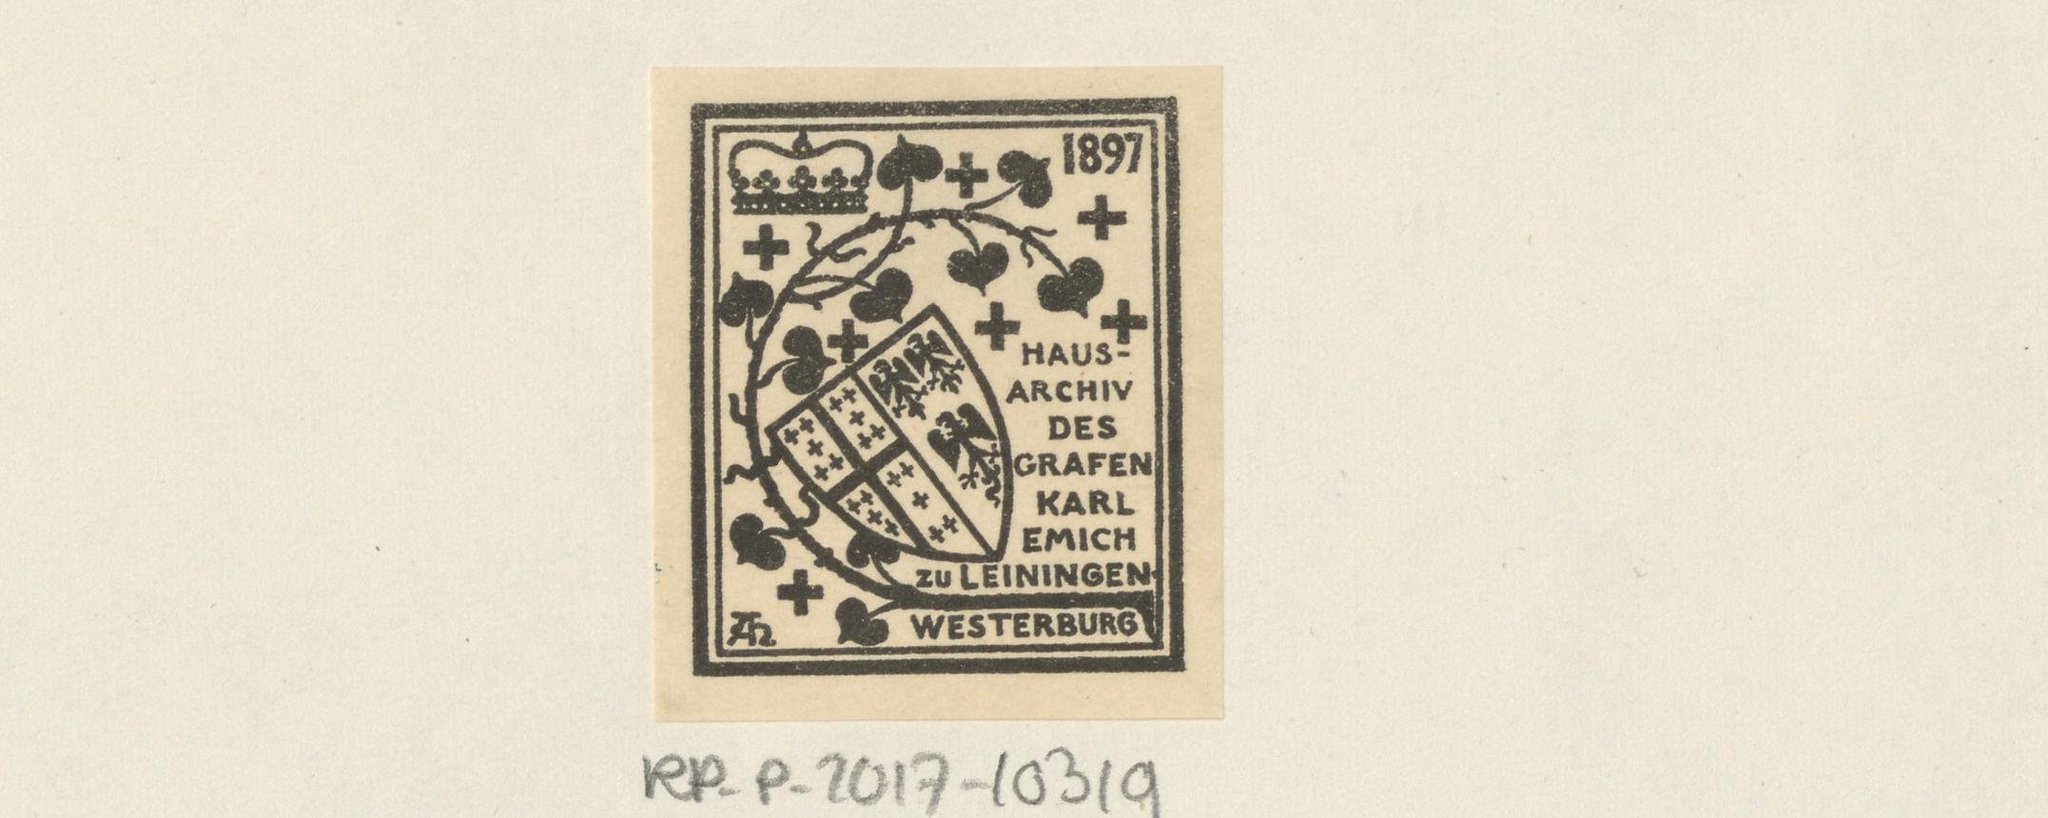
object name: bookplate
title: Ex libris van Karl Emich zu Leiningen Westerburg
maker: adolf matthias hildebrandt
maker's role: auteur, genealoog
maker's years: 1844-1918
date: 1897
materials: paper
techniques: lithograph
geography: germany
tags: crown (symbol of sovereignty), plants and herbs, armorial bearing, heraldry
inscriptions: date